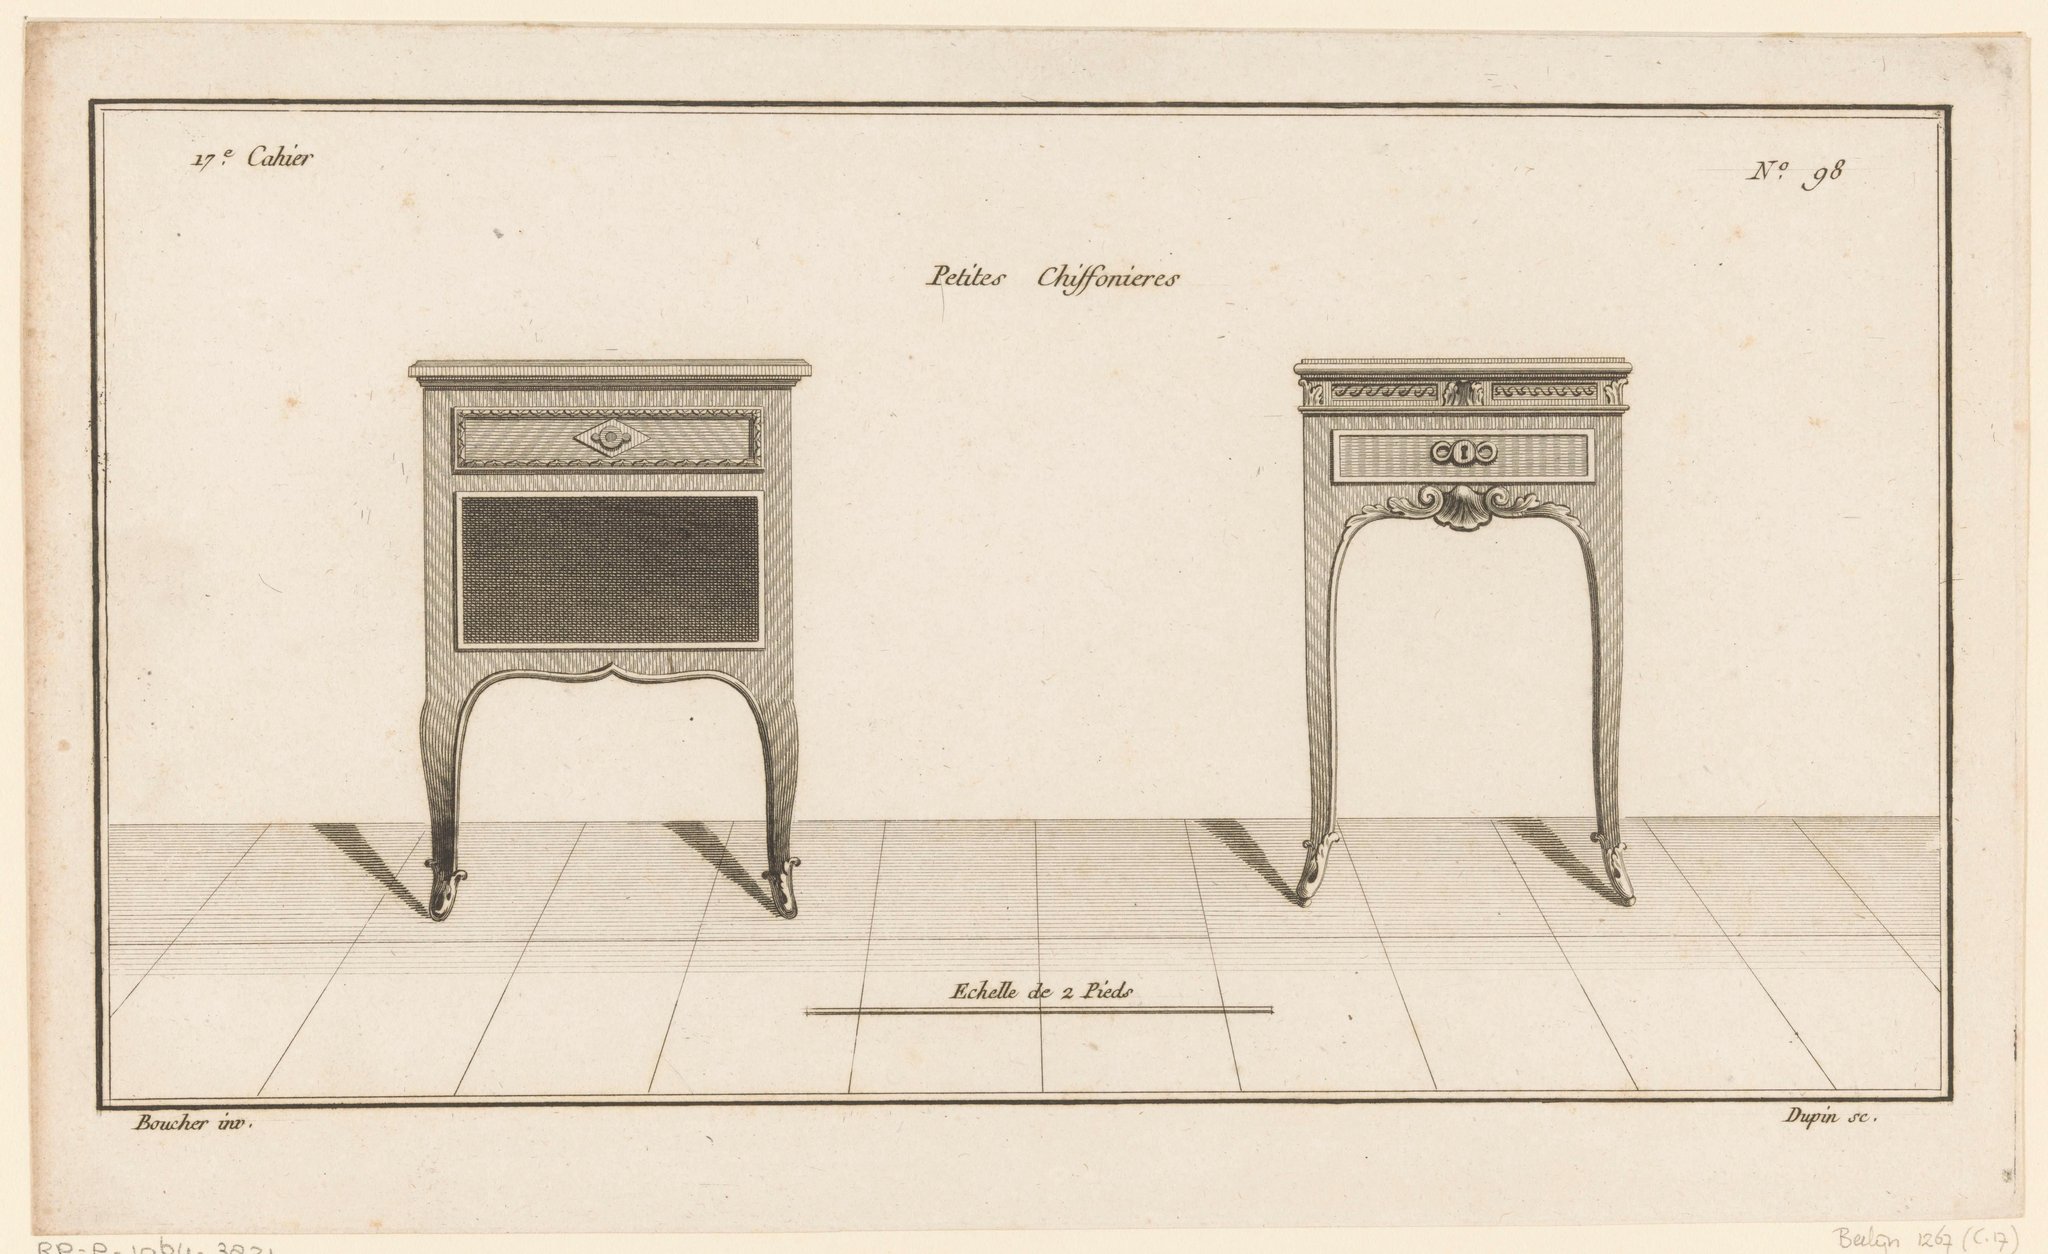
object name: print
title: Twee chiffonieres met schelpmotief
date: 1772-1779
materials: paper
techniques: engraving, etching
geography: paris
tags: scallop, shell ~ ornament, furniture to put things on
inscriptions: collector's mark: Lugt 2228, collector's mark: Lugt 2760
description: Twee geornamenteerde chiffonieres, rechts met schelpmotief. Prentnummer.